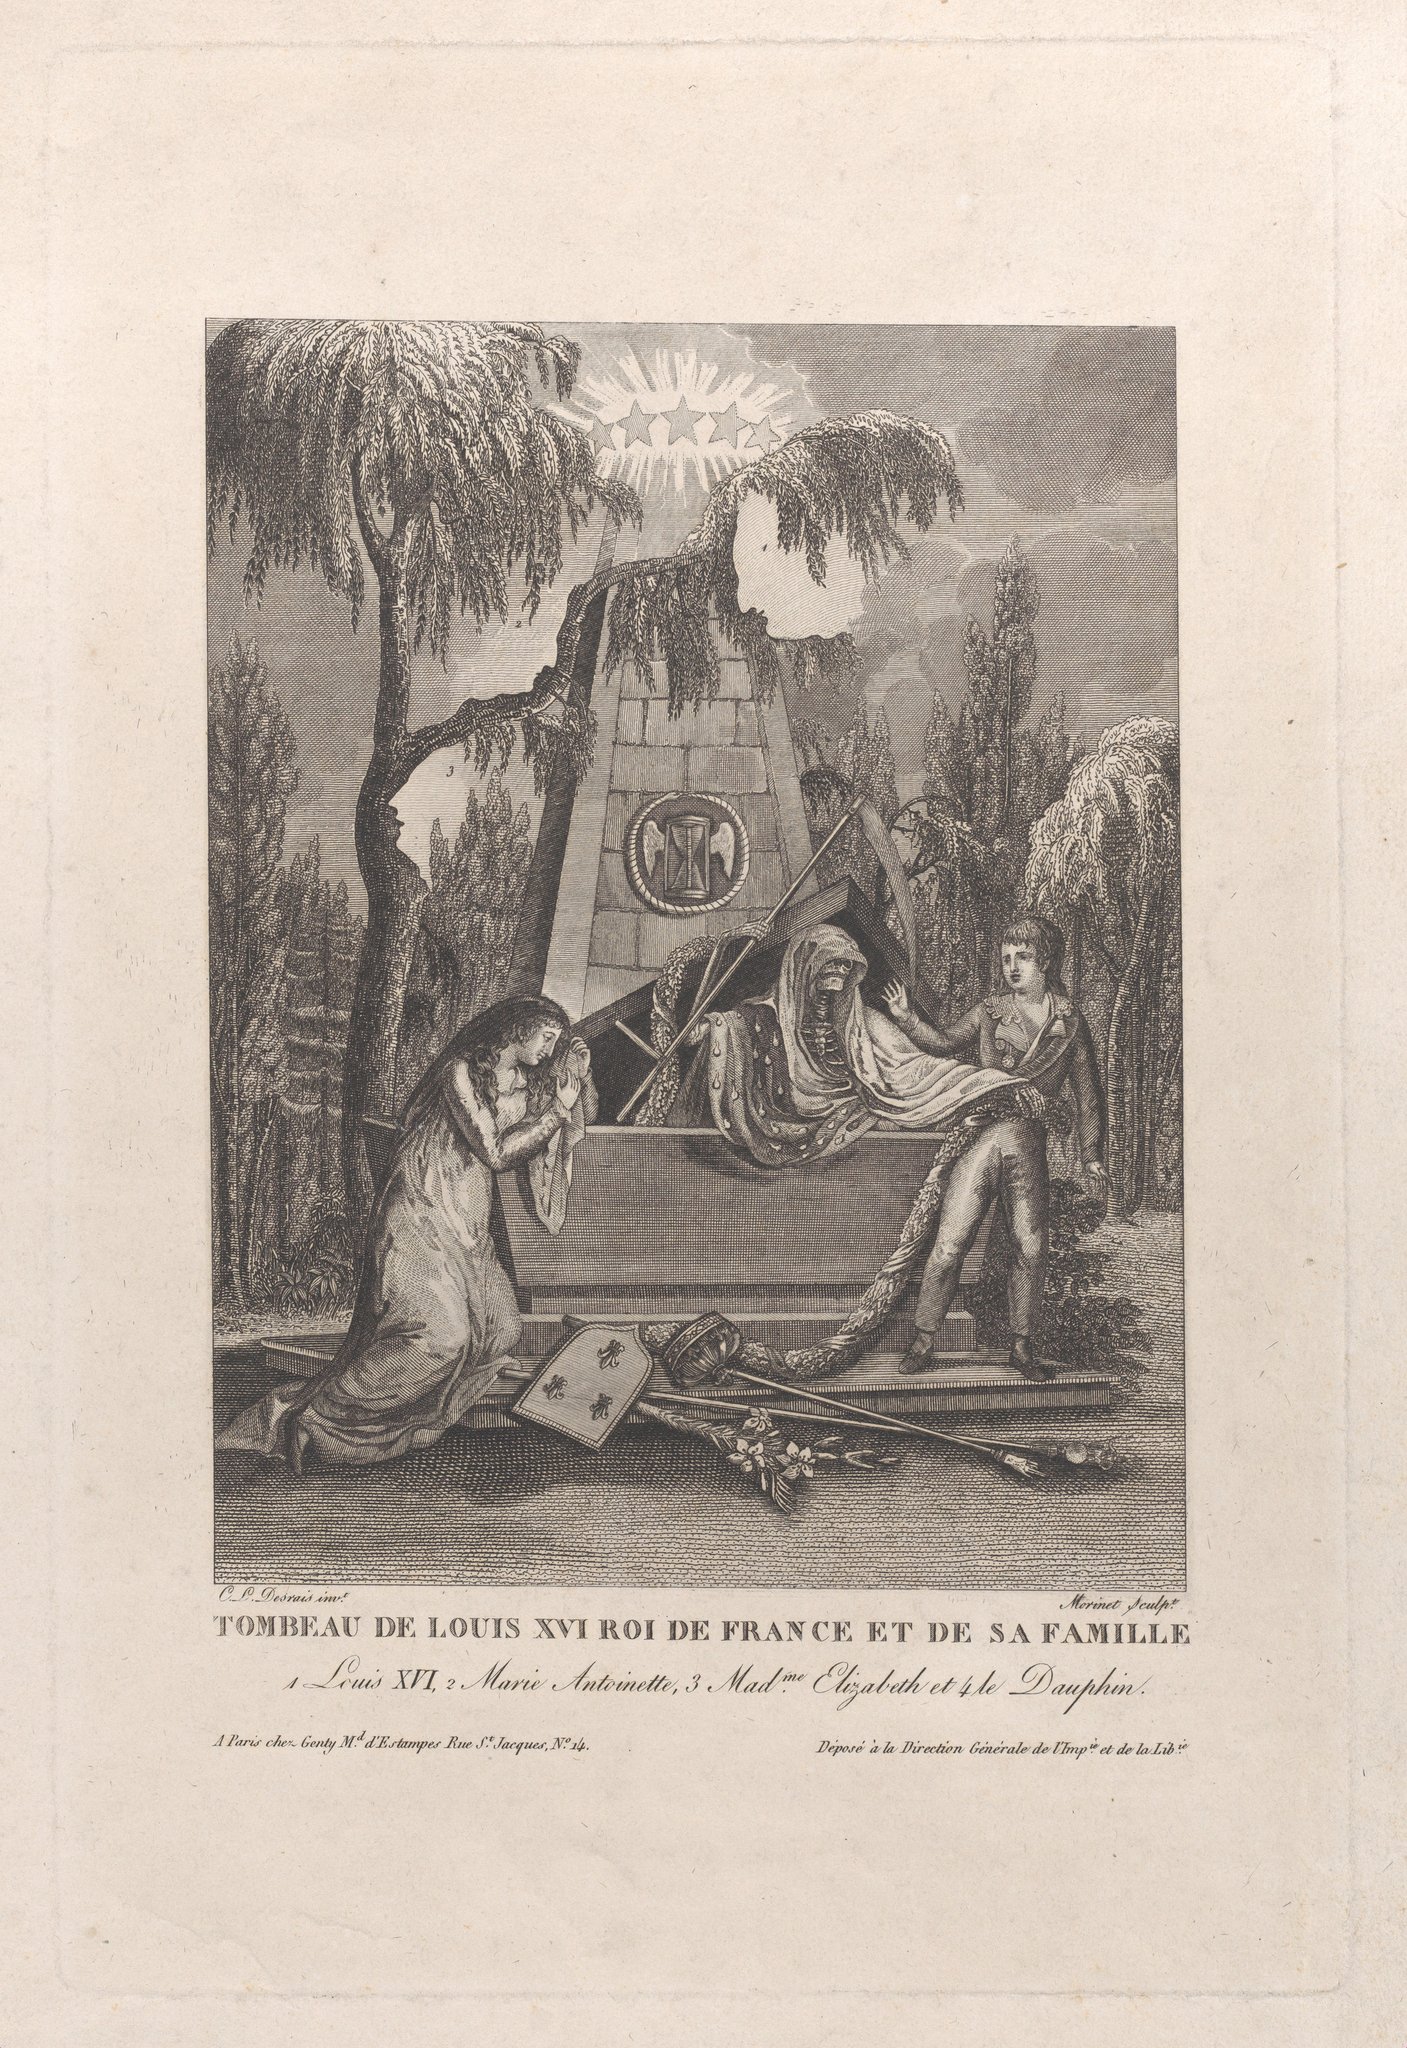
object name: print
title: Tomb of Louis XVI and his family, with hidden silhouettes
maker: Anonymous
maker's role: artist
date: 1793-1800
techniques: engraving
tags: tombs,louis xvi,marie antoinette,skeletons